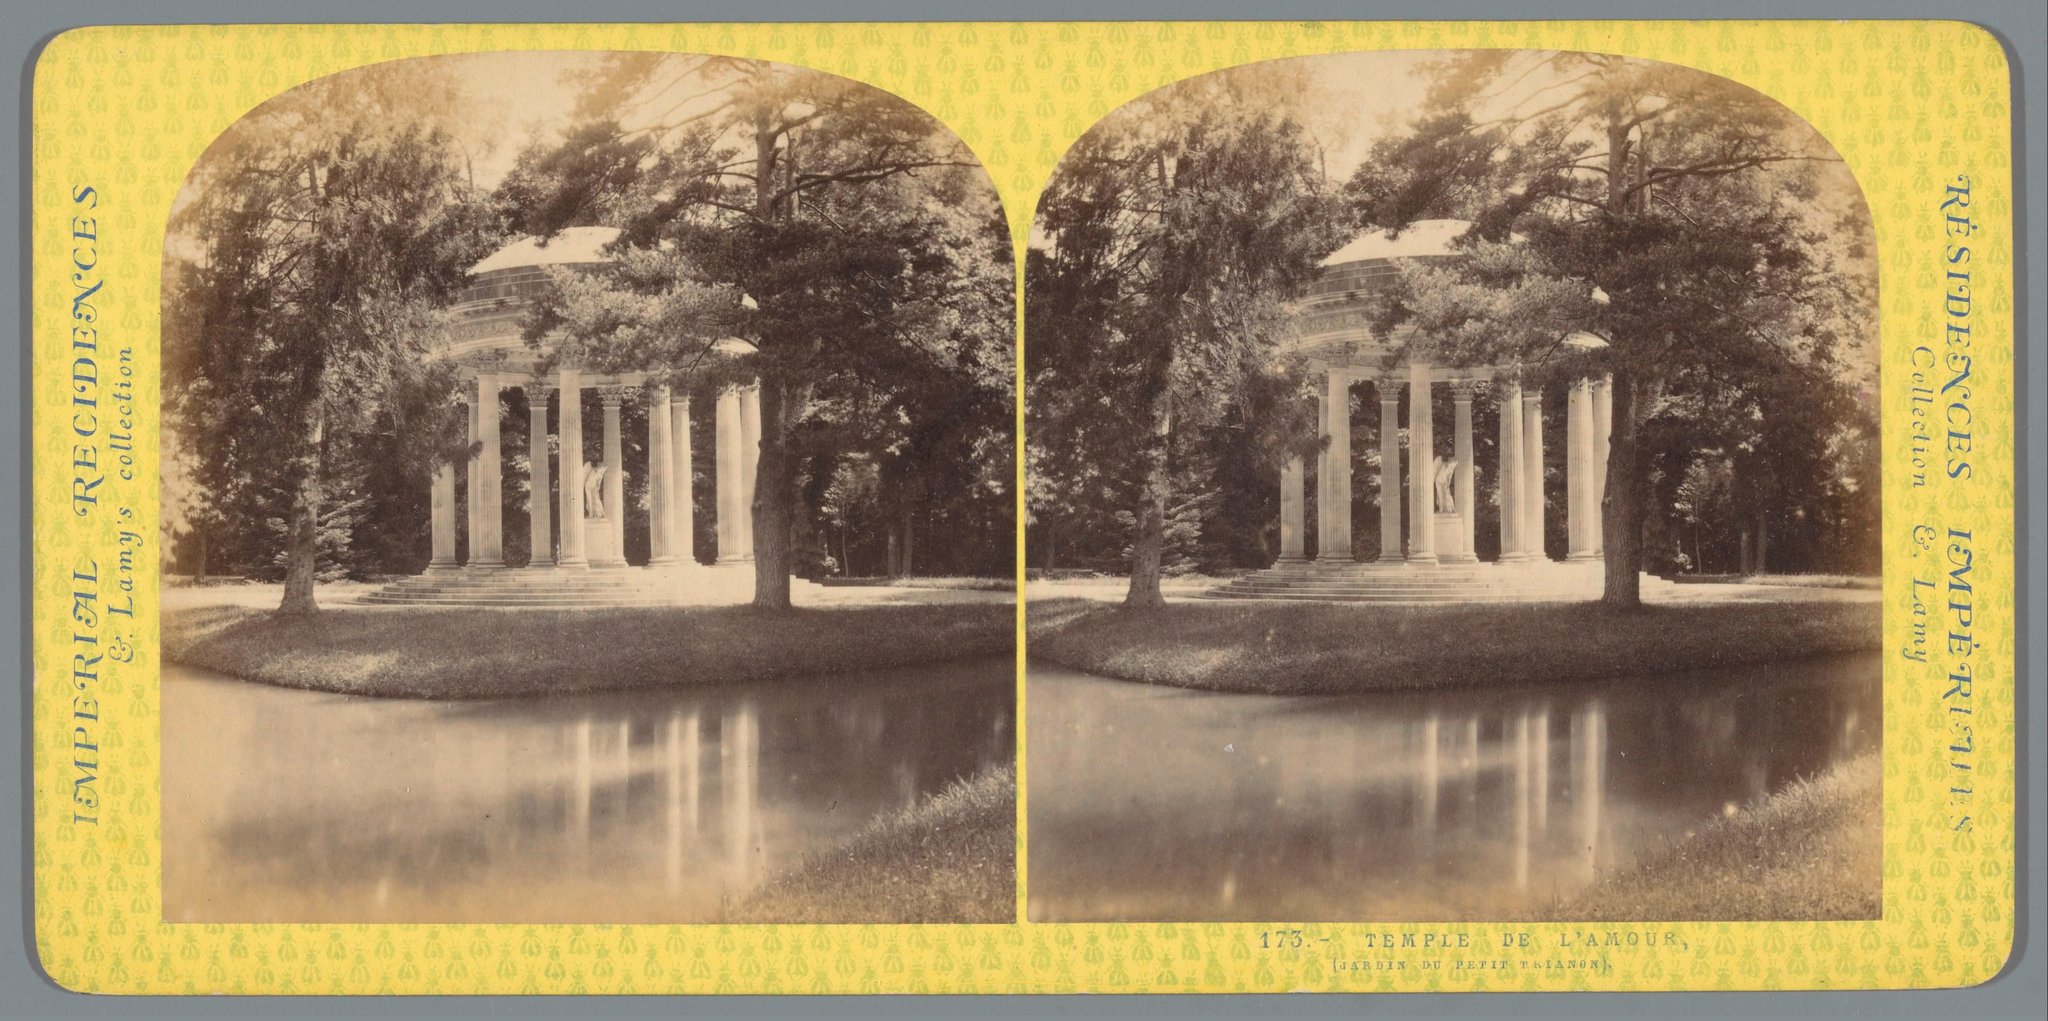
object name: stereograph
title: Temple de l'Amour, (Jardin du Petit Trianon)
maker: ernest eléonor pierre lamy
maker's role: publisher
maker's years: 1828-1900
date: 1860-1880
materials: cardboard, photographic support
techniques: albumen print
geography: jardins du petit trianon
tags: architectural folly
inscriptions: inscription: ‘E. Lamy's collection’, number: ‘173.’